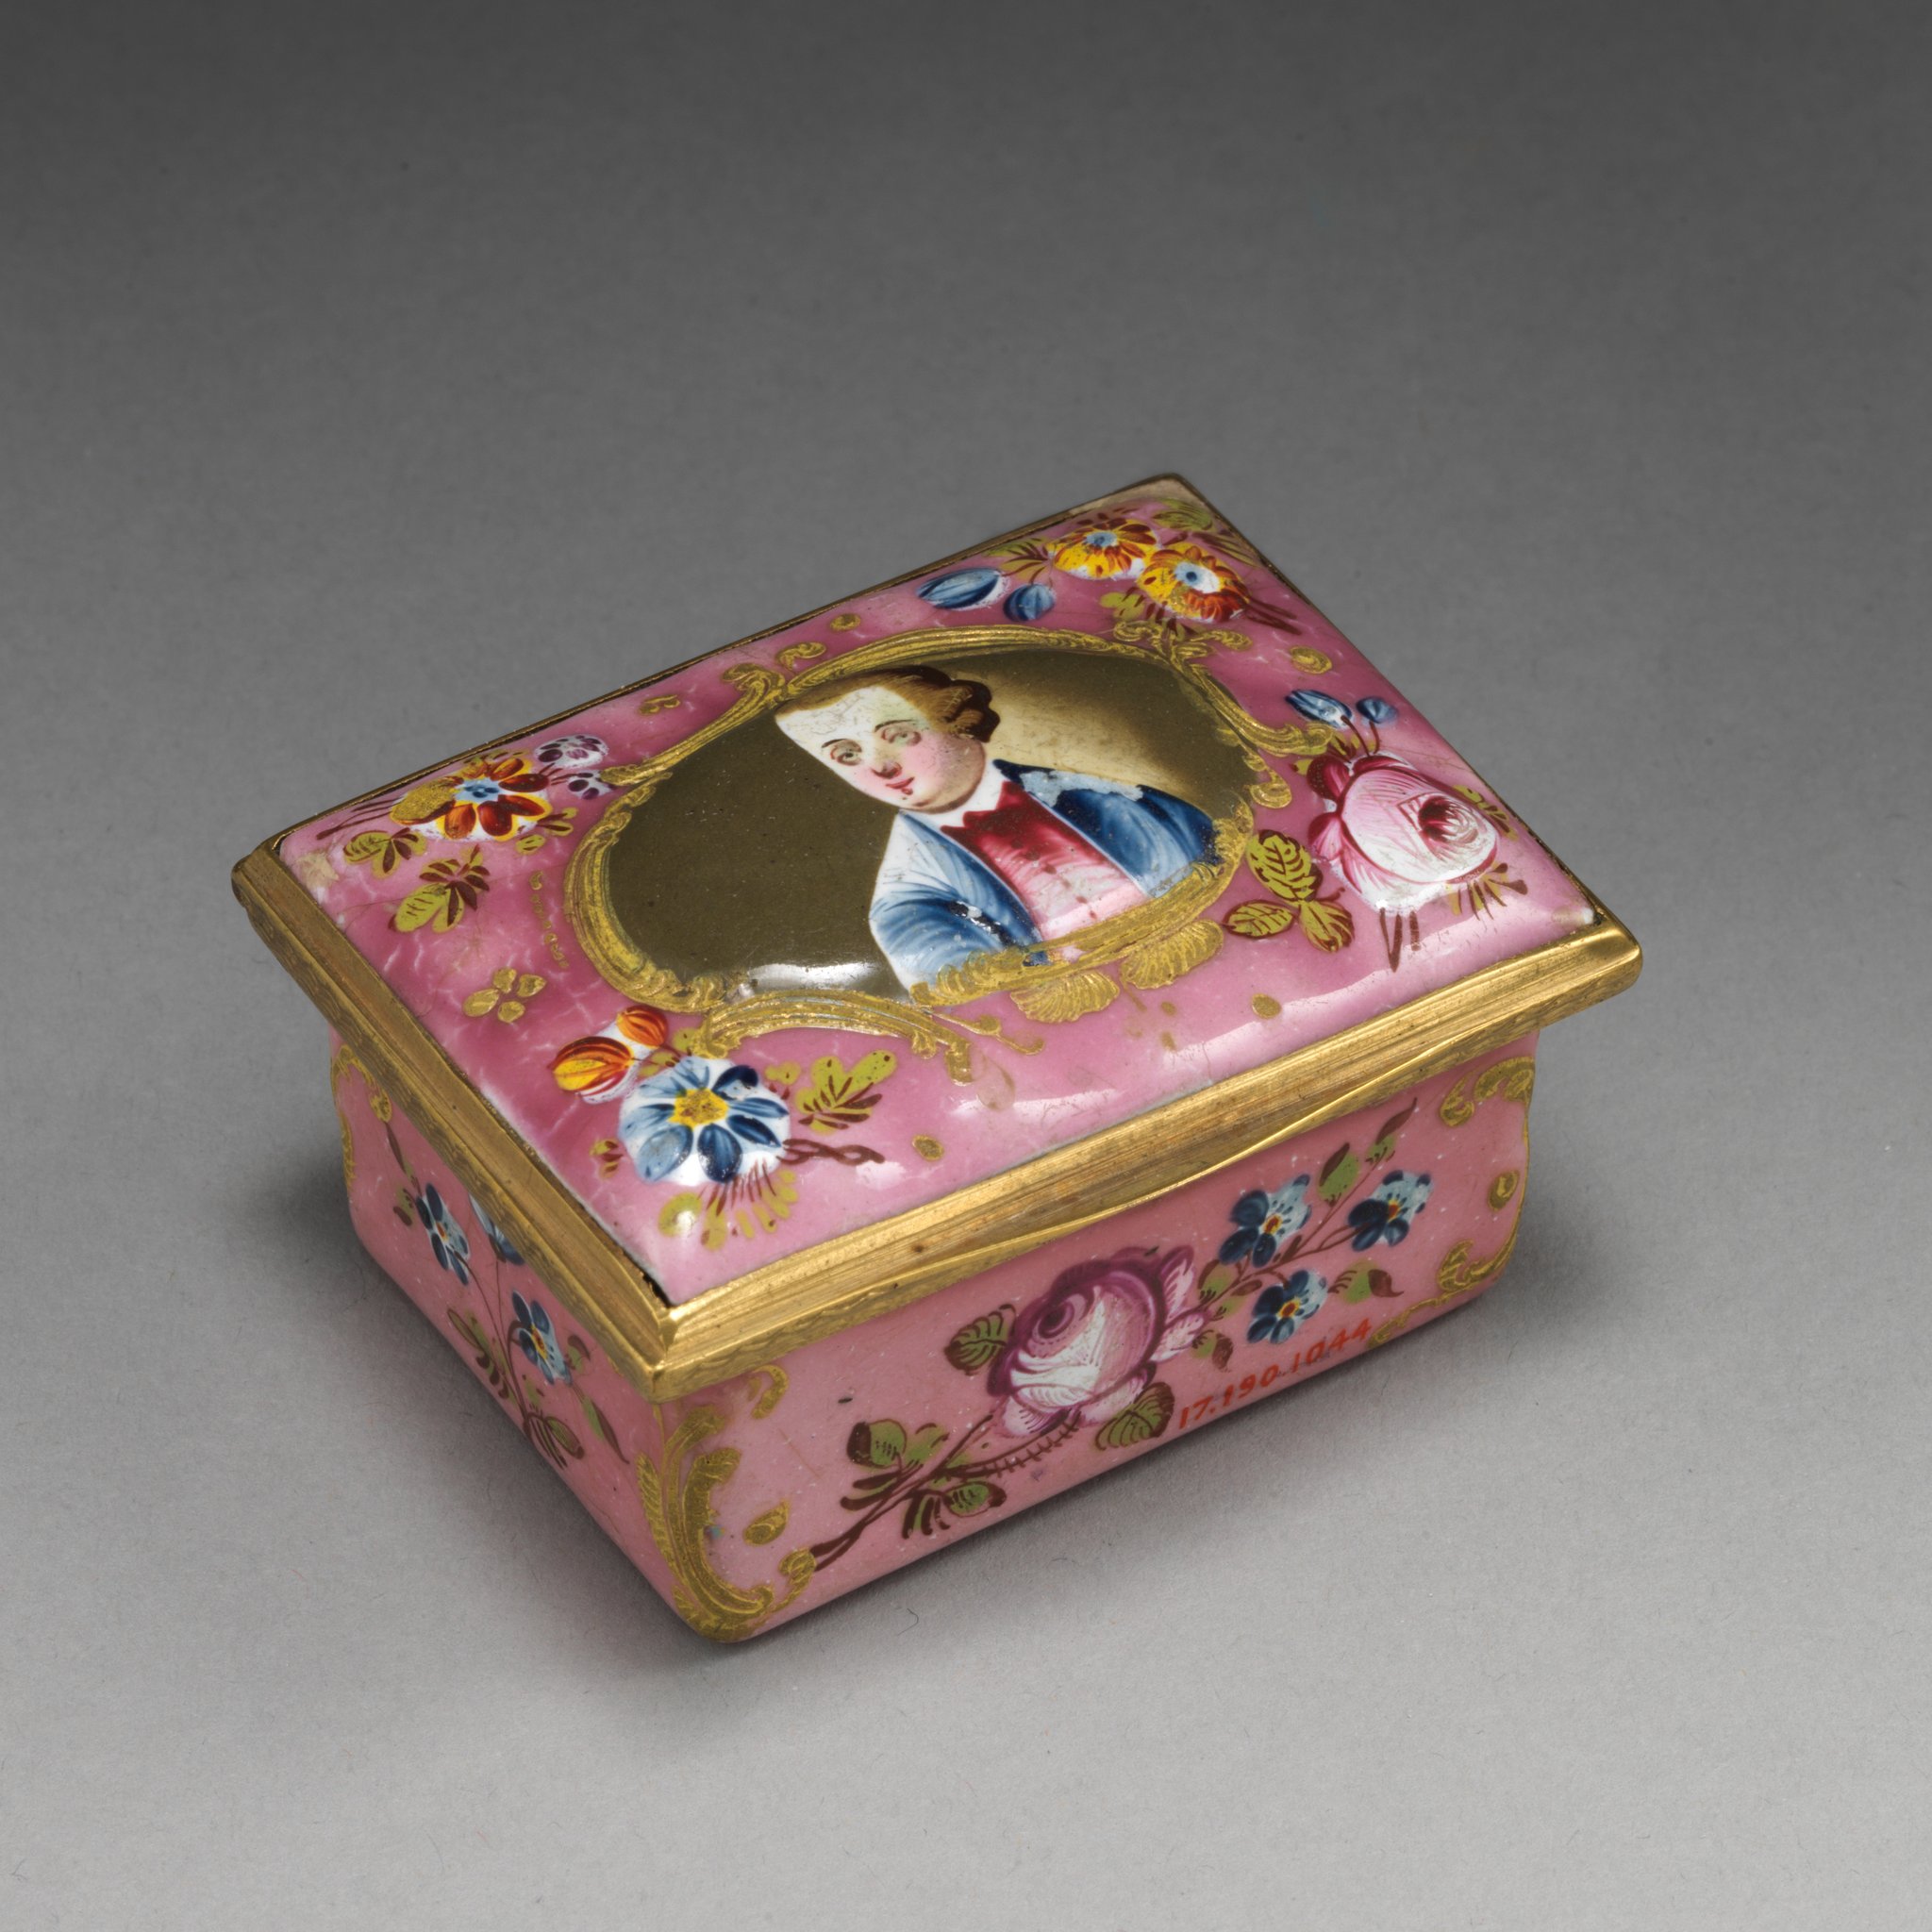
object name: snuffbox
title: Snuffbox with portrait of an unidentified man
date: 1770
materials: copper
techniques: enamel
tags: men,portraits,flowers